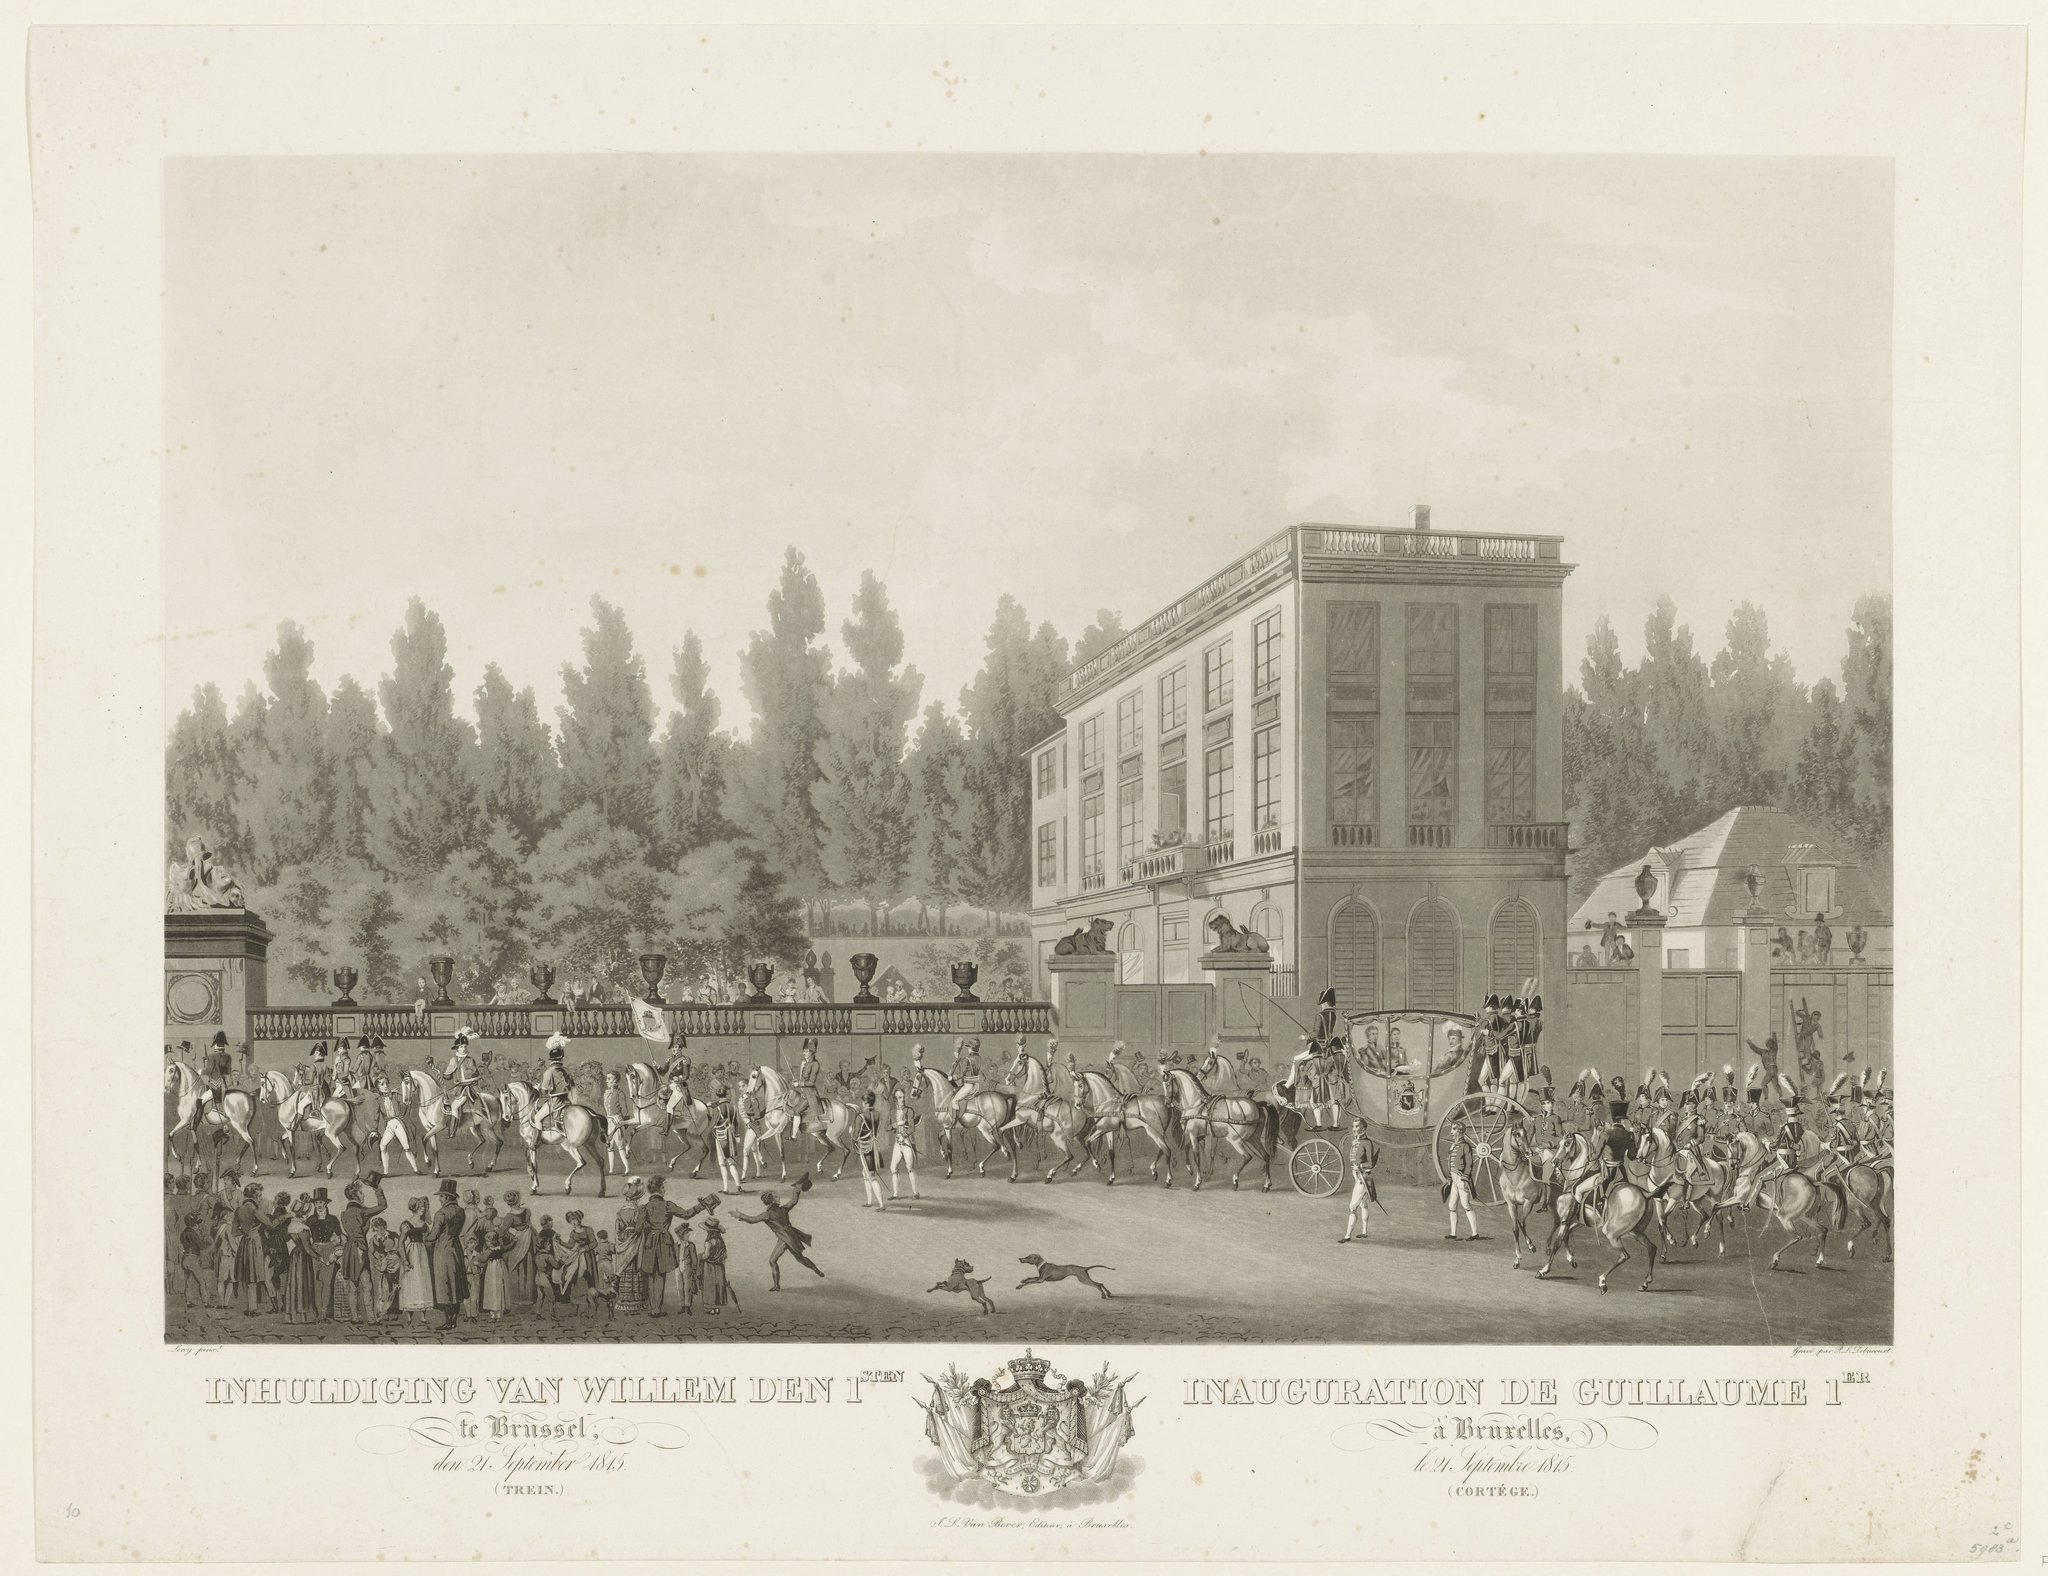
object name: history print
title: Twaalf platen van de aankomst en inhuldiging van Willem I in Brussel en de slagen bij Quatre-Bras en Waterloo in 1815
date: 1825-1826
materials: paper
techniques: aquatint, etching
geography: brussels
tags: the hague, berlin, william i of the netherlands, triumphal entry and public reception, pageant, 'entrée solennelle', 'joyeuse entrée', brussels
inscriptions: collector's mark: Lugt 2228, workshop stamp: ‘JLVB’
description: Plechtige intrede van de stoet voor de inhuldiging van koning Willem I te Brussel op 21 september 1815. Aankomst van de hofkoets met koning Willem I, getrokken door acht paarden. Onderaan de titels in het Nederlands en Frans gescheiden door het wapen van koning Willem I. Onderdeel van een serie platen van de aankomst en inhuldiging van Willem I in Brussel.